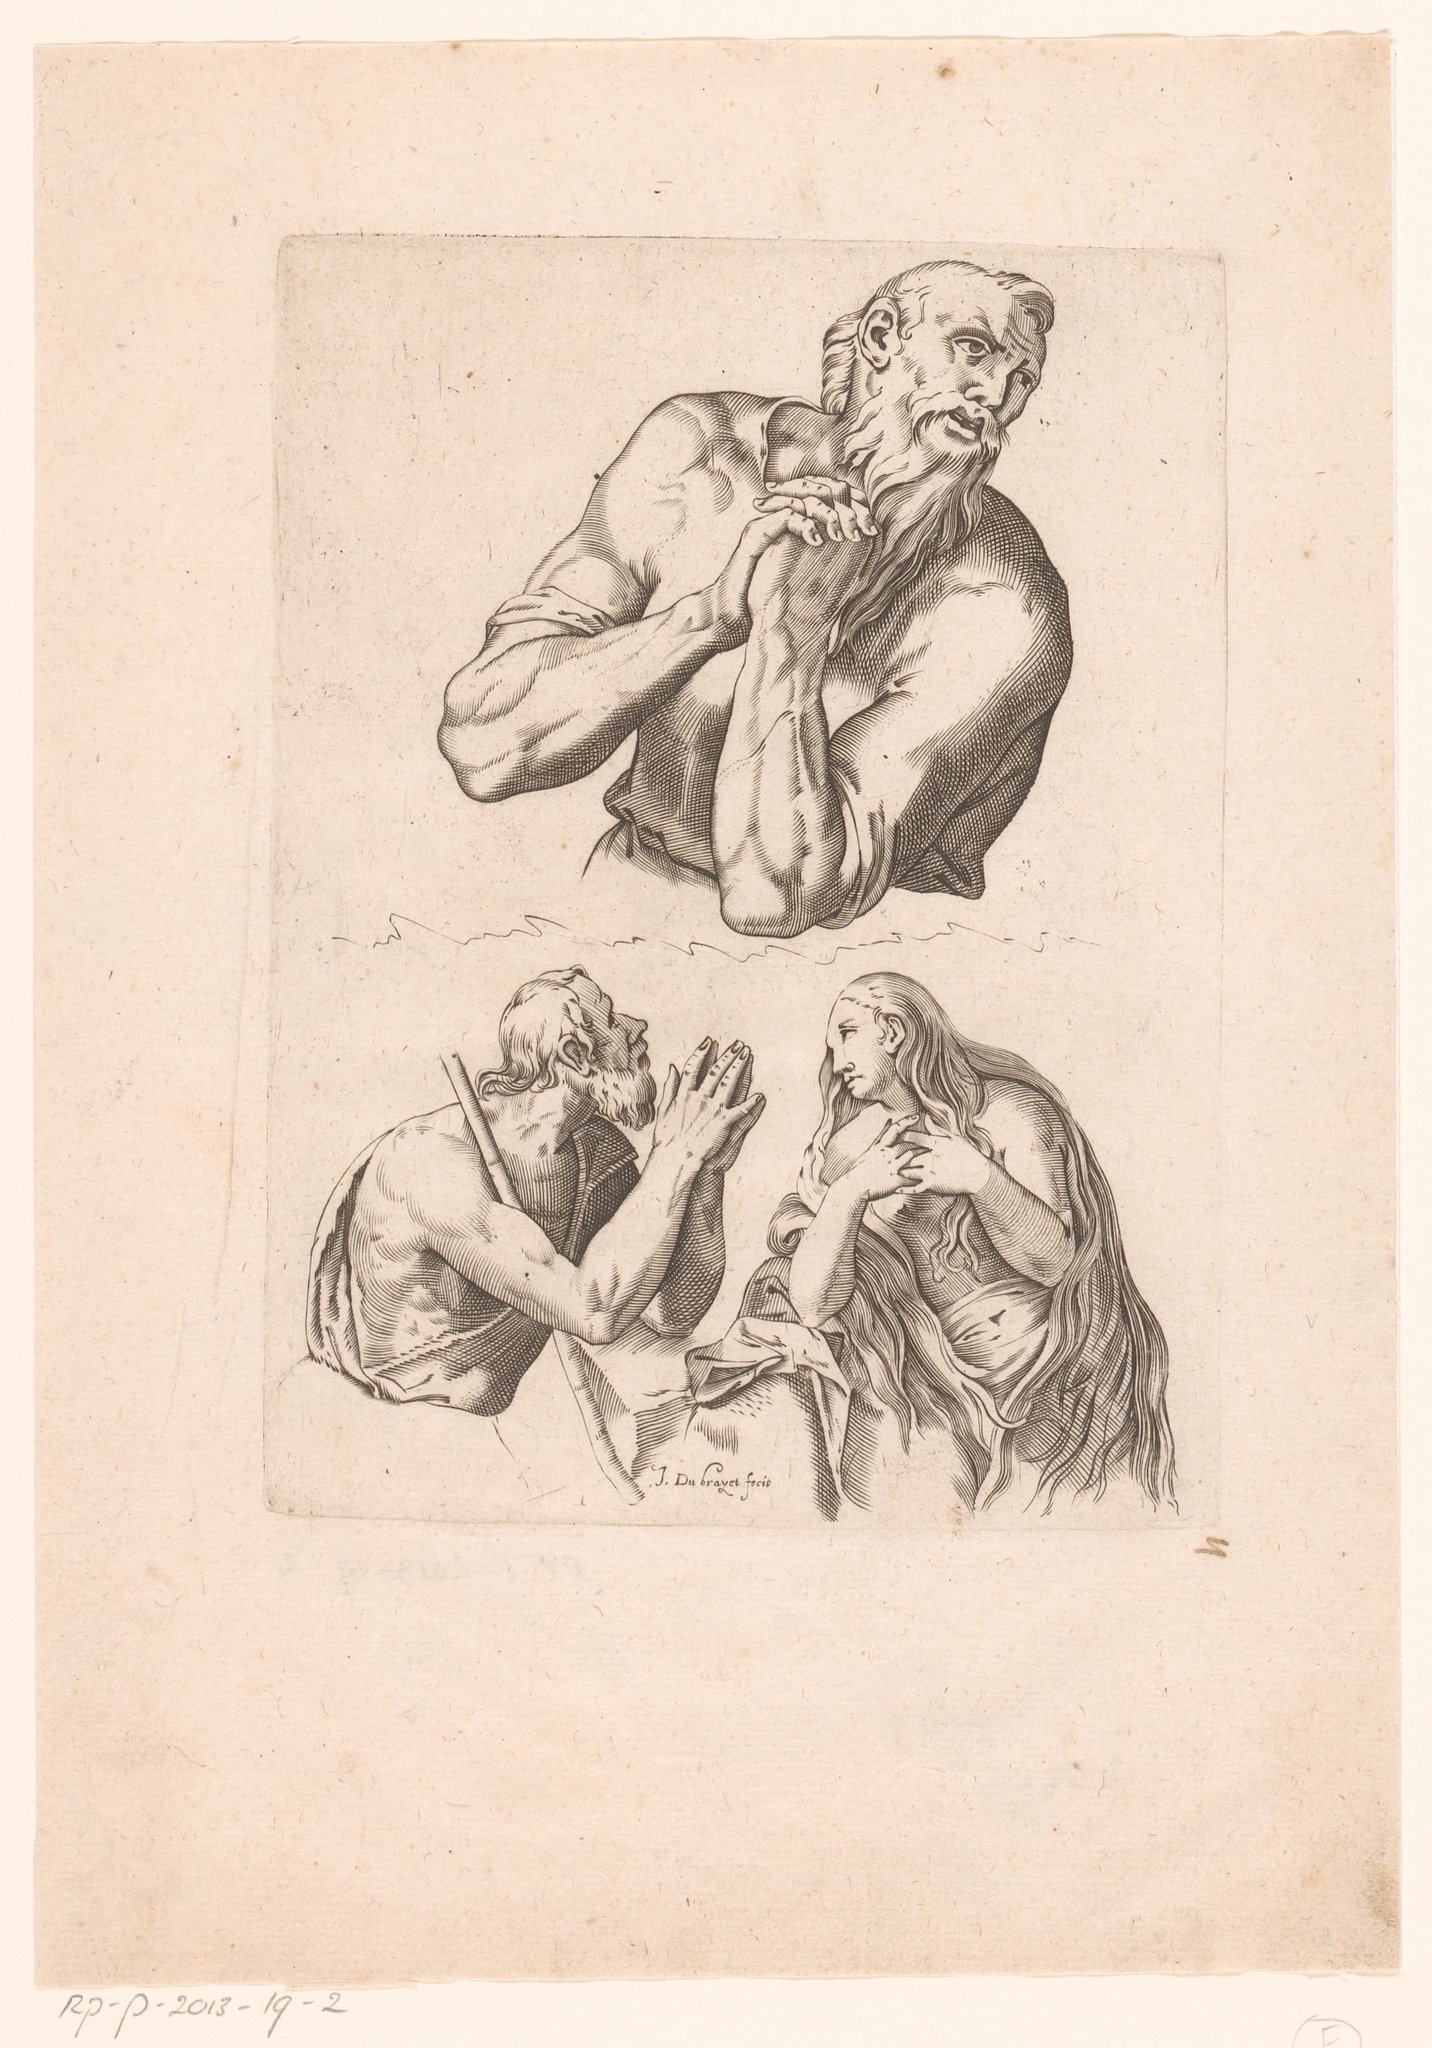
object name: print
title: Compositie met smekende figuren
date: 1627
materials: paper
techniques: engraving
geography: paris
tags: adult woman, adult man, hands folded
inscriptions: collector's mark: Lugt 2228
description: Prent uit: s.n. Livre de portraiture receuilli des excellens maistres d’Italie et autres. Parijs: Jean Messager, ca. 1627.